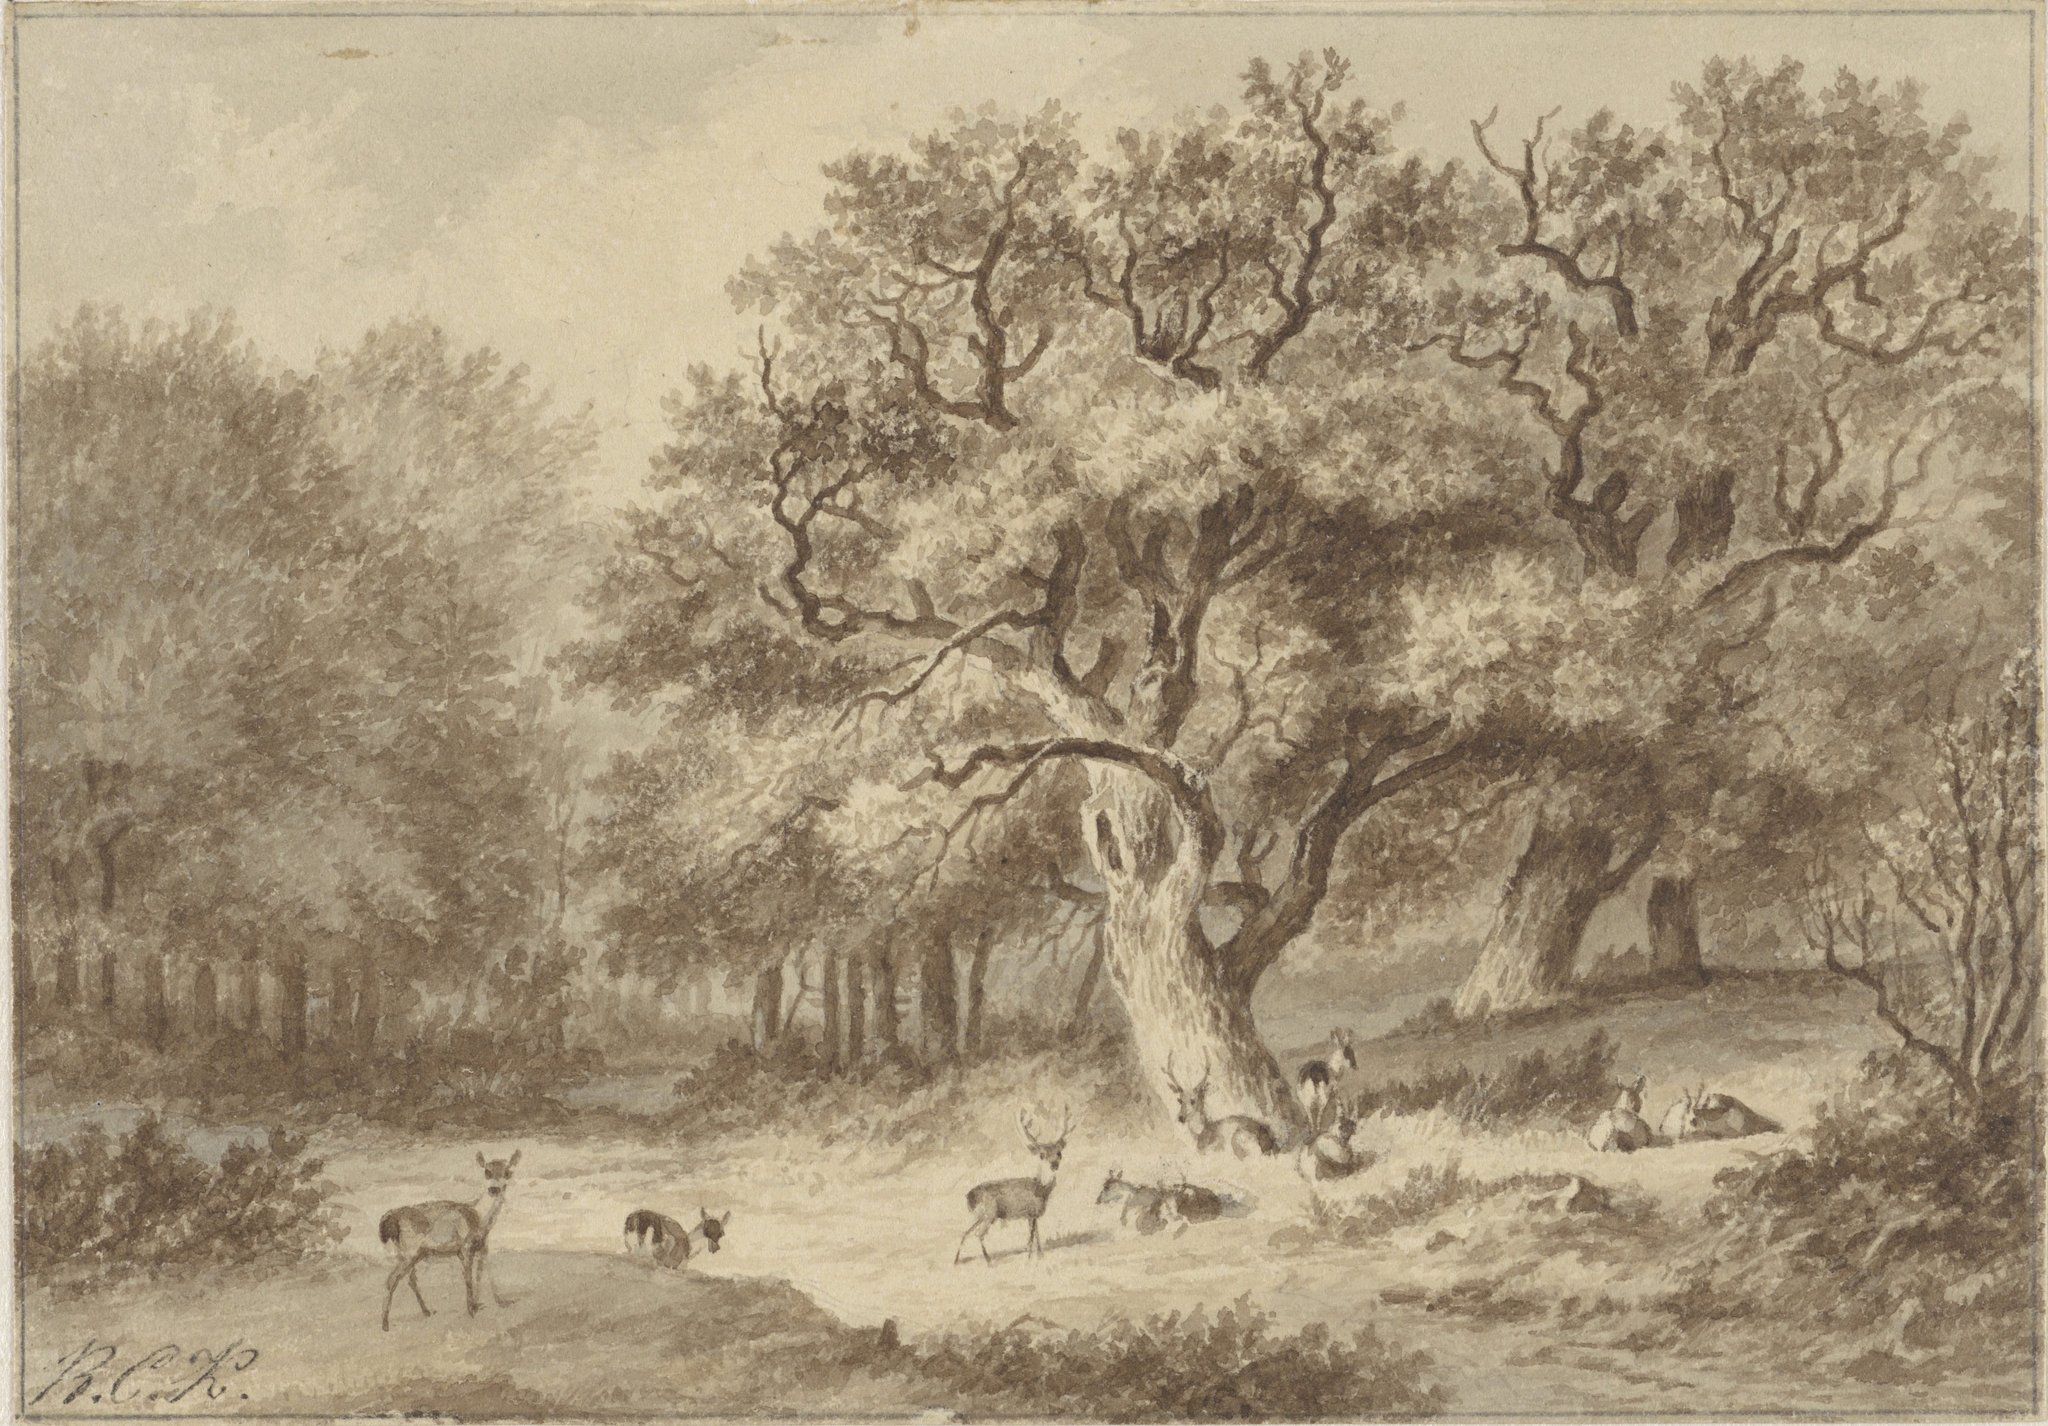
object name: drawing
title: Boslandschap met herten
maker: barend cornelis koekkoek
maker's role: draughtsman, painter, print maker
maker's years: 1803-1862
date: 1813-1862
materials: paper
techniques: brush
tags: forest, wood